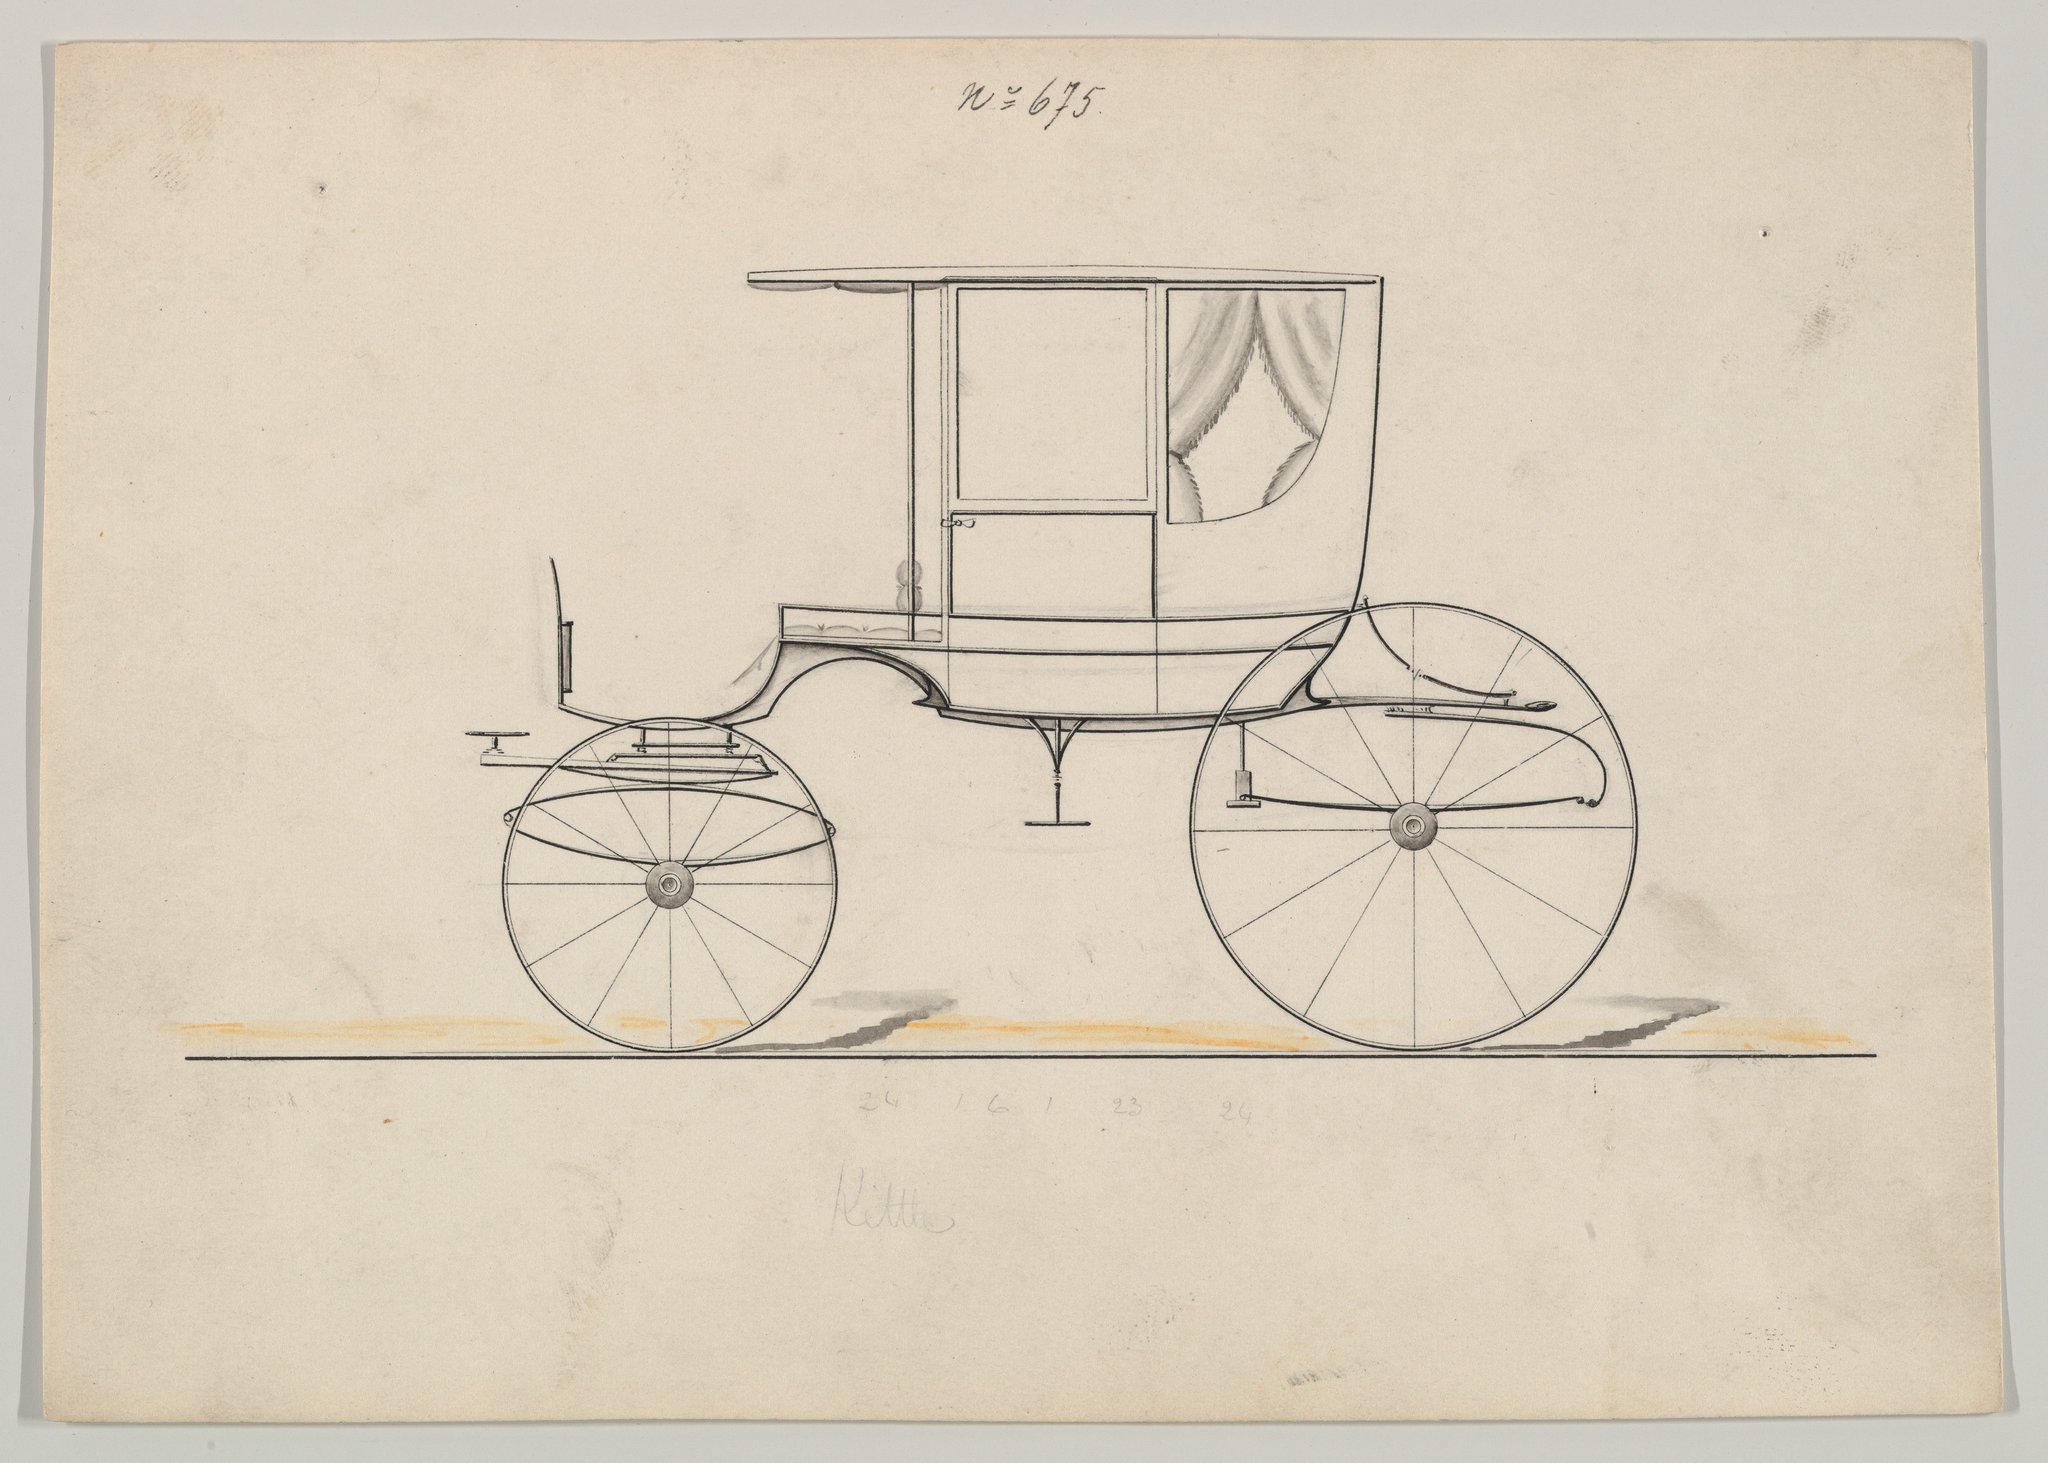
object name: drawing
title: Rockaway #675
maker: brewster & co.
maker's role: manufacturer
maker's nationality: american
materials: ink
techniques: pen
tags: carriages